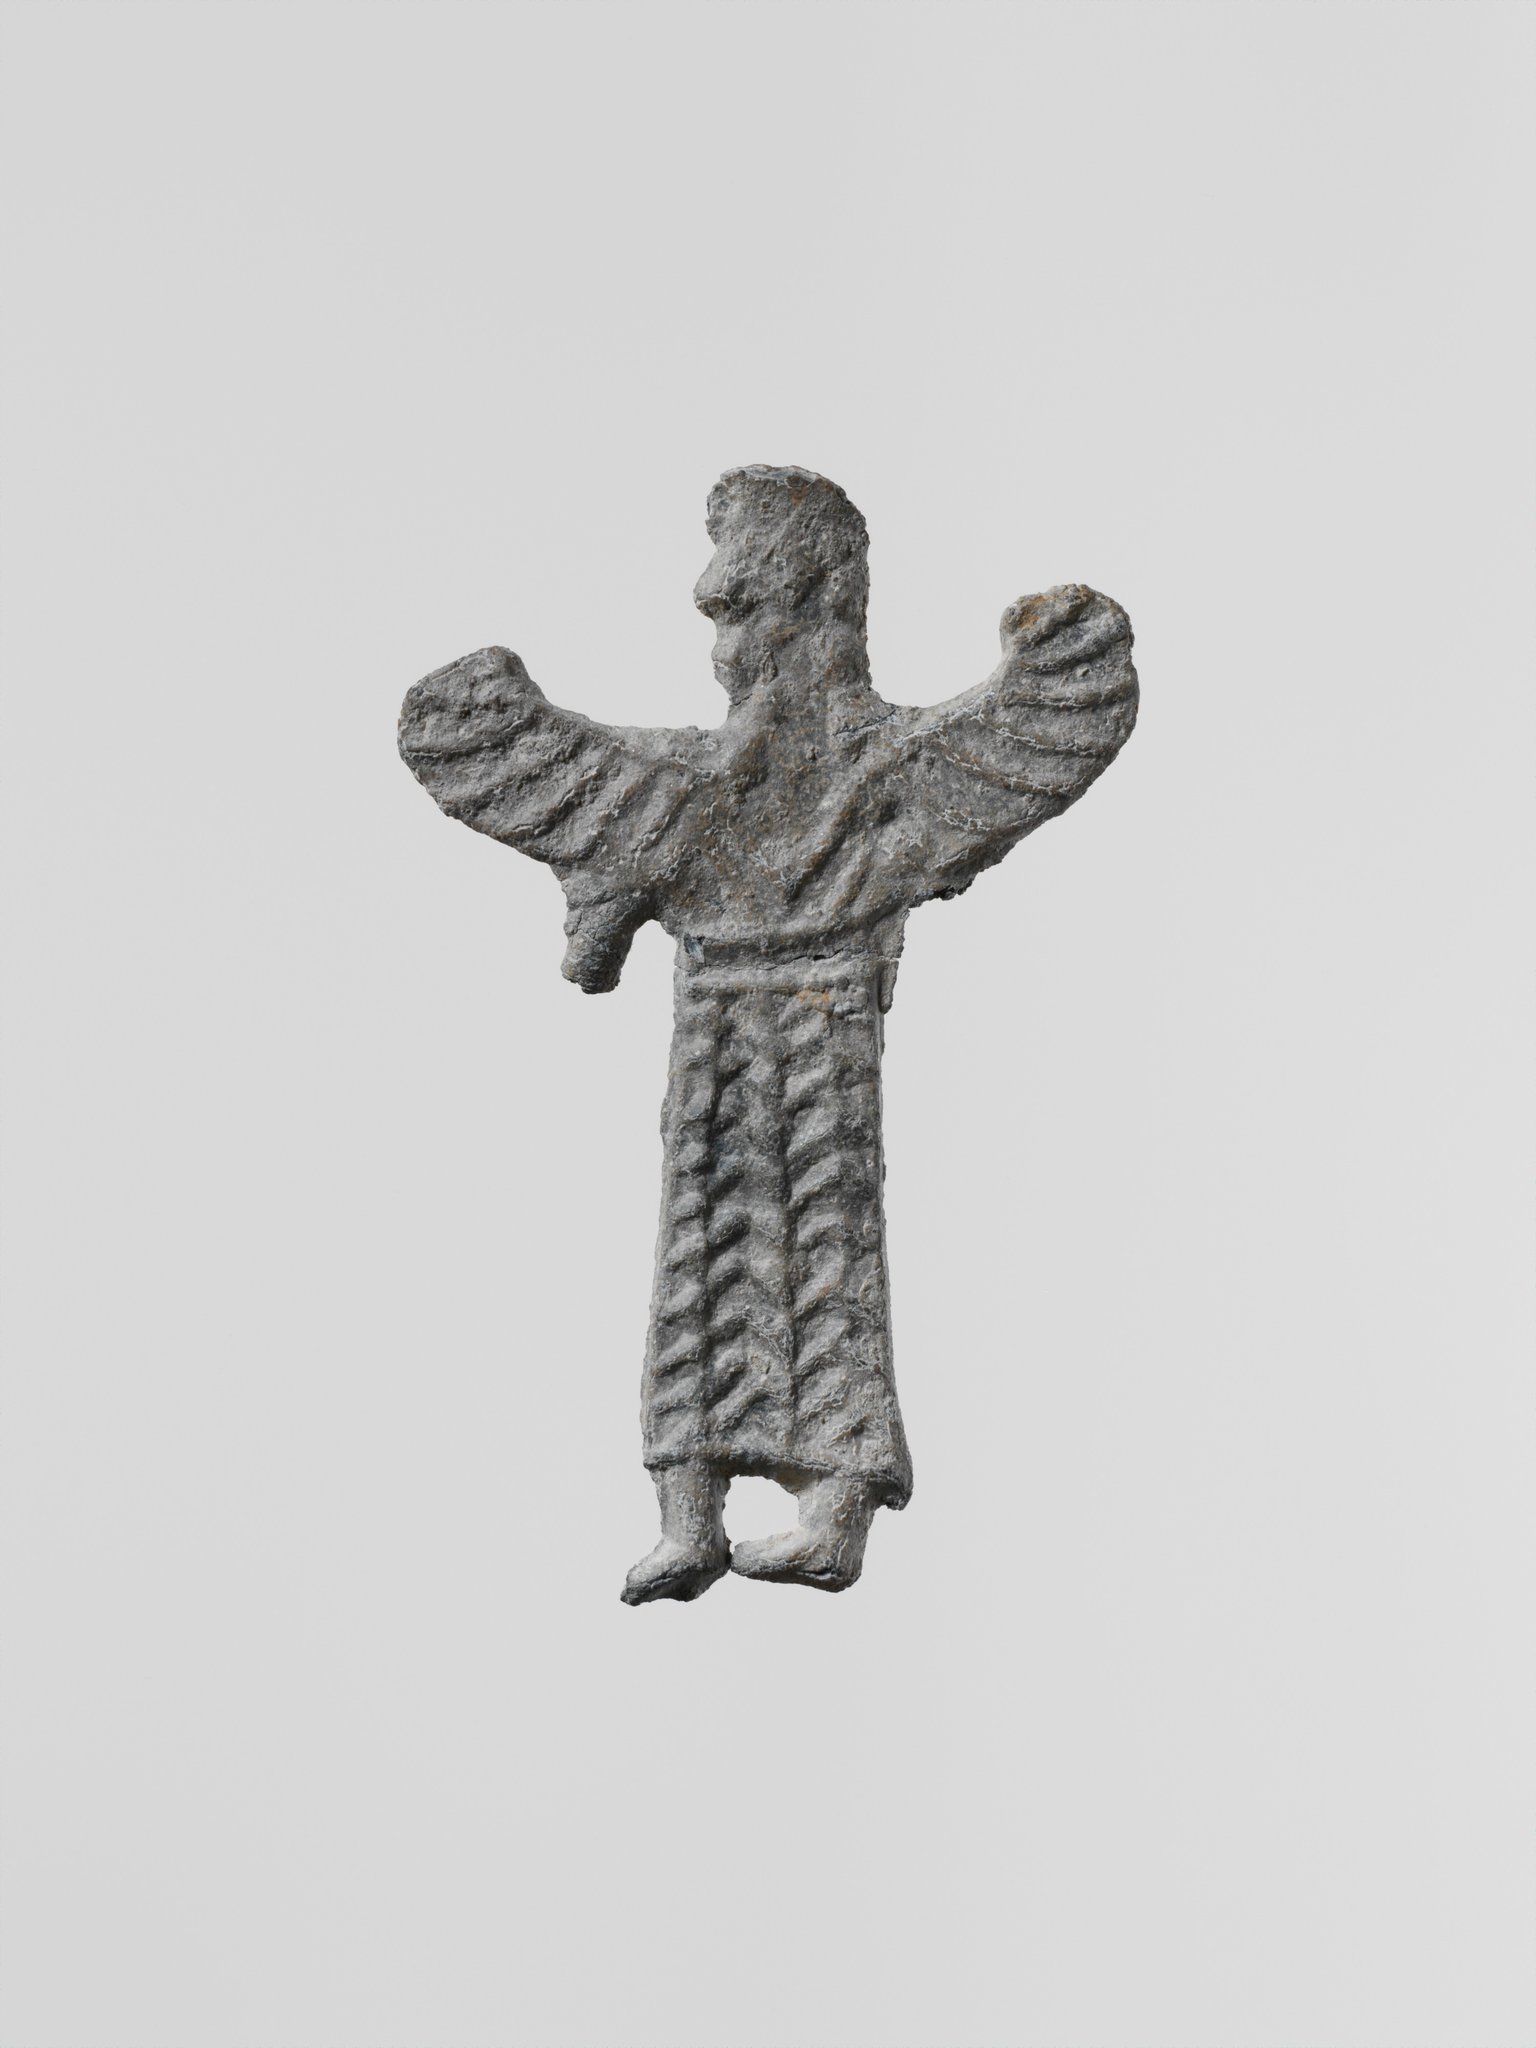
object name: statuette of artemis orthia, winged, 8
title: Lead figure of a winged goddess, possibly Artemis Orthia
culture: greek, laconian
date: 634-501 BCE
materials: lead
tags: artemis,goddess